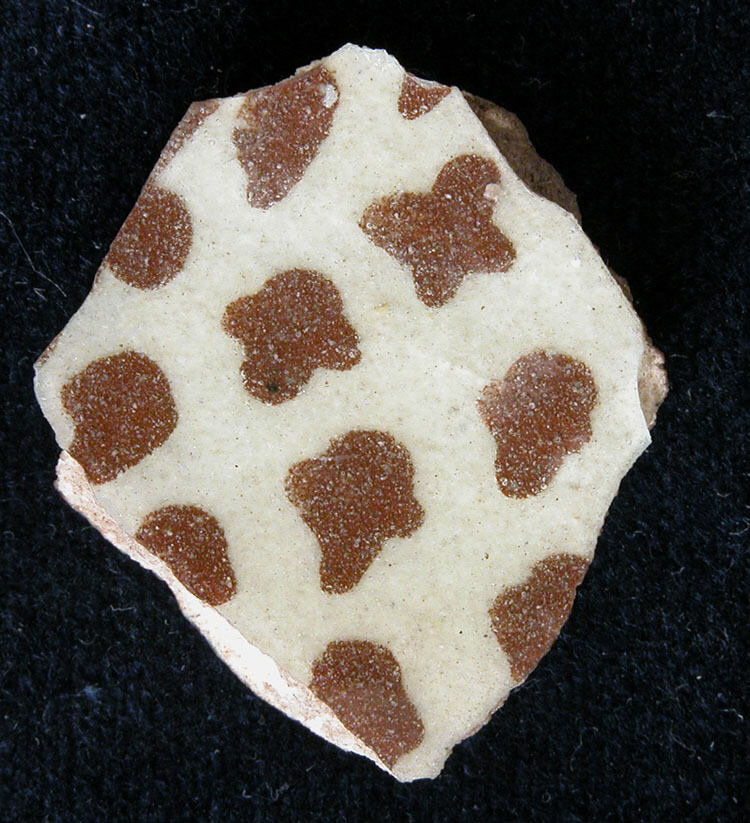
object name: fragment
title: Ceramic Fragment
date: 1201-1300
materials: stonepaste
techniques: luster painting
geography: syria